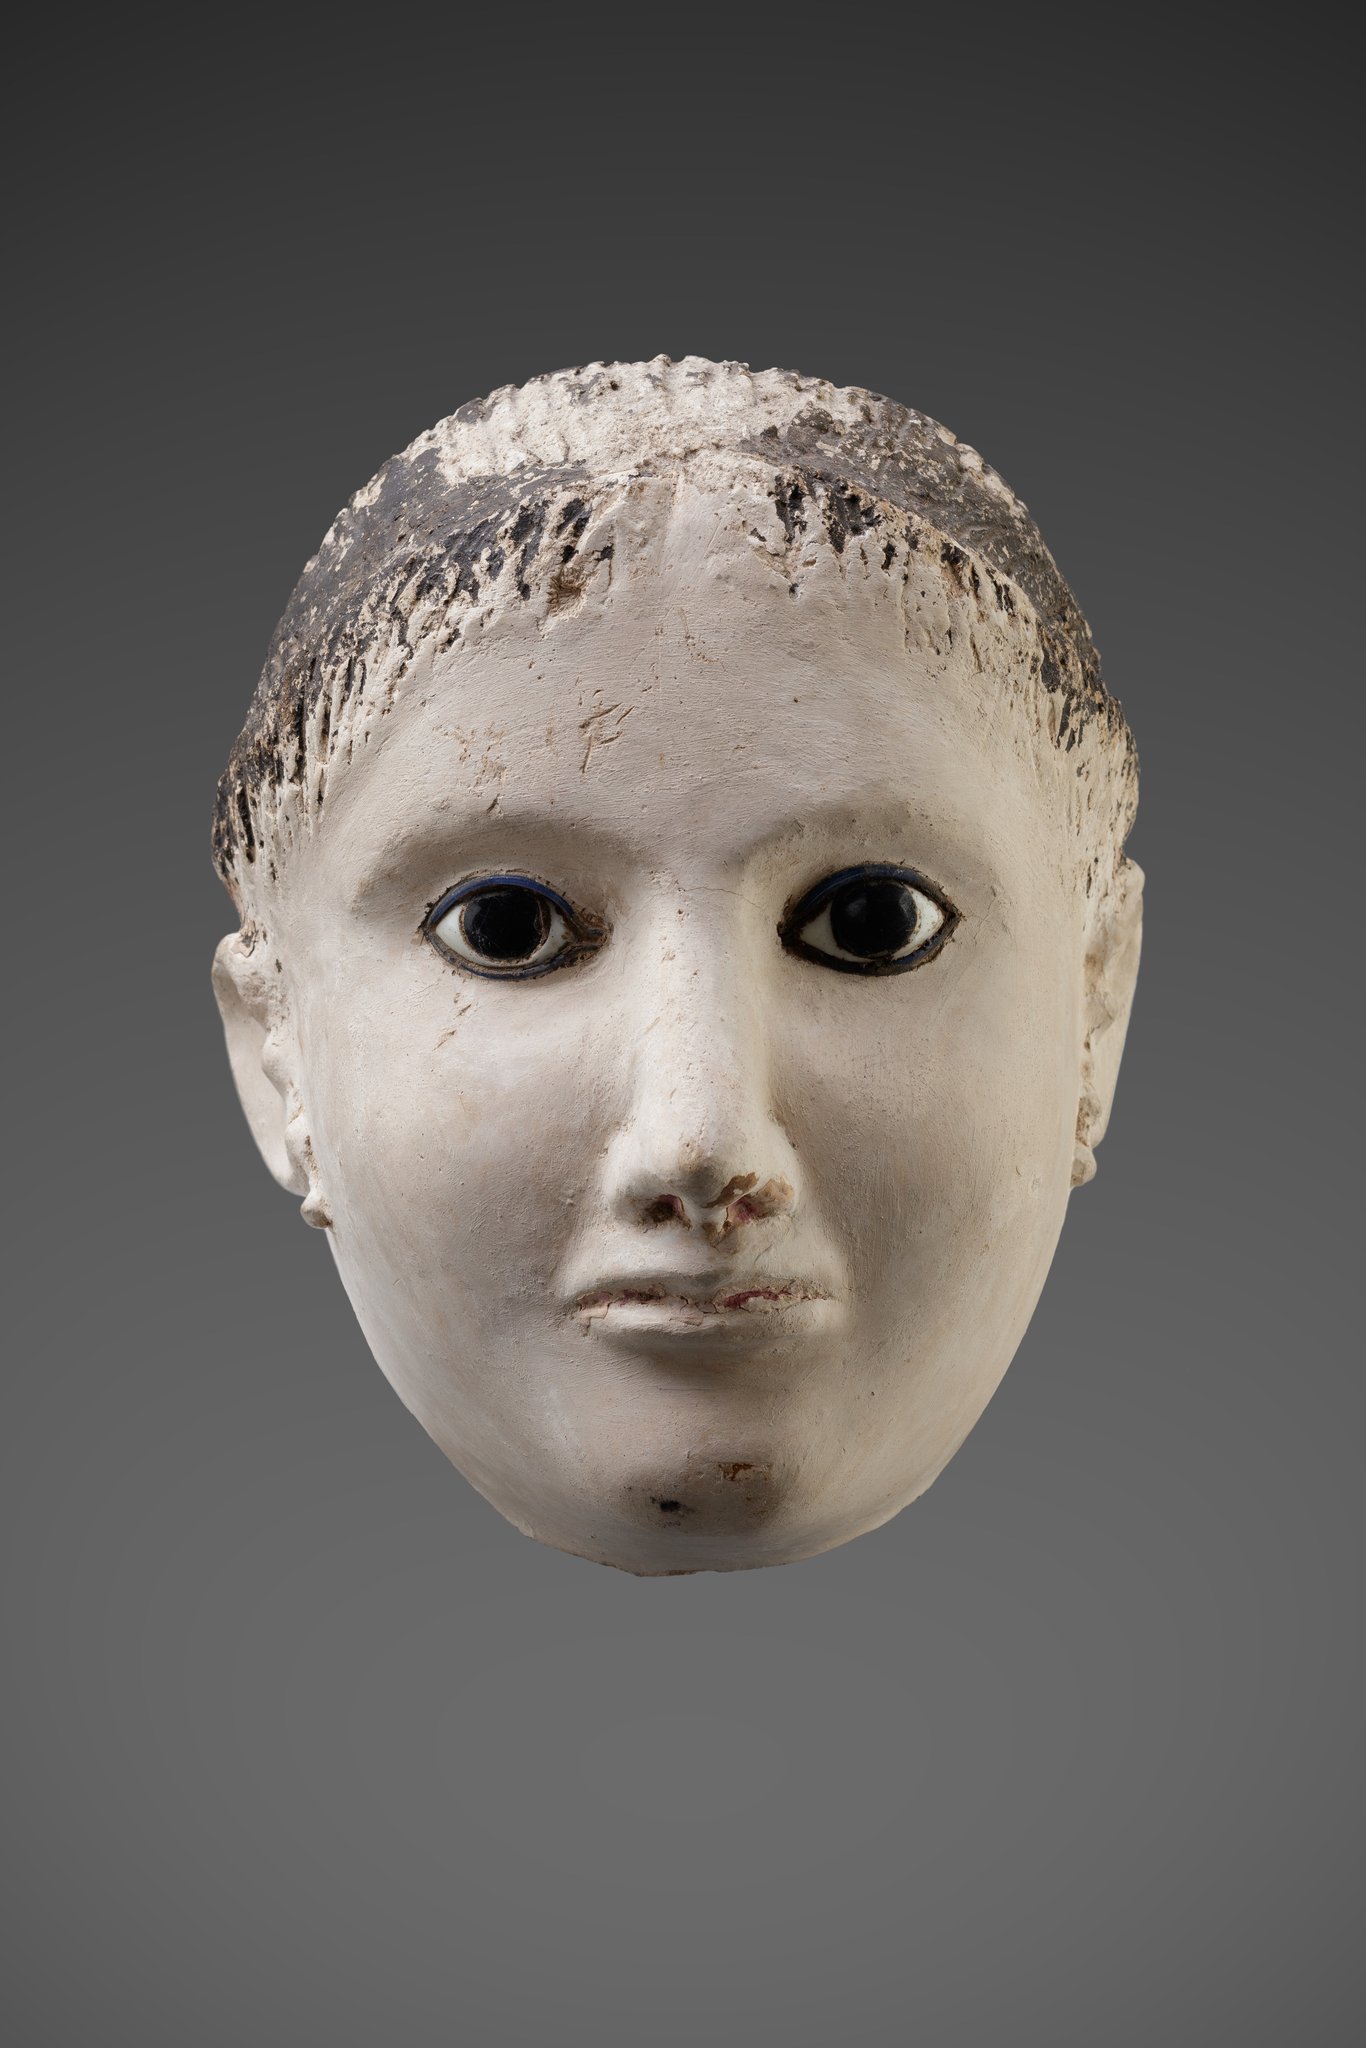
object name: mask, woman, hair rolled back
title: Mask of a woman with her hair rolled back at the forehead and temples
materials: glass, paint, plaster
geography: egypt